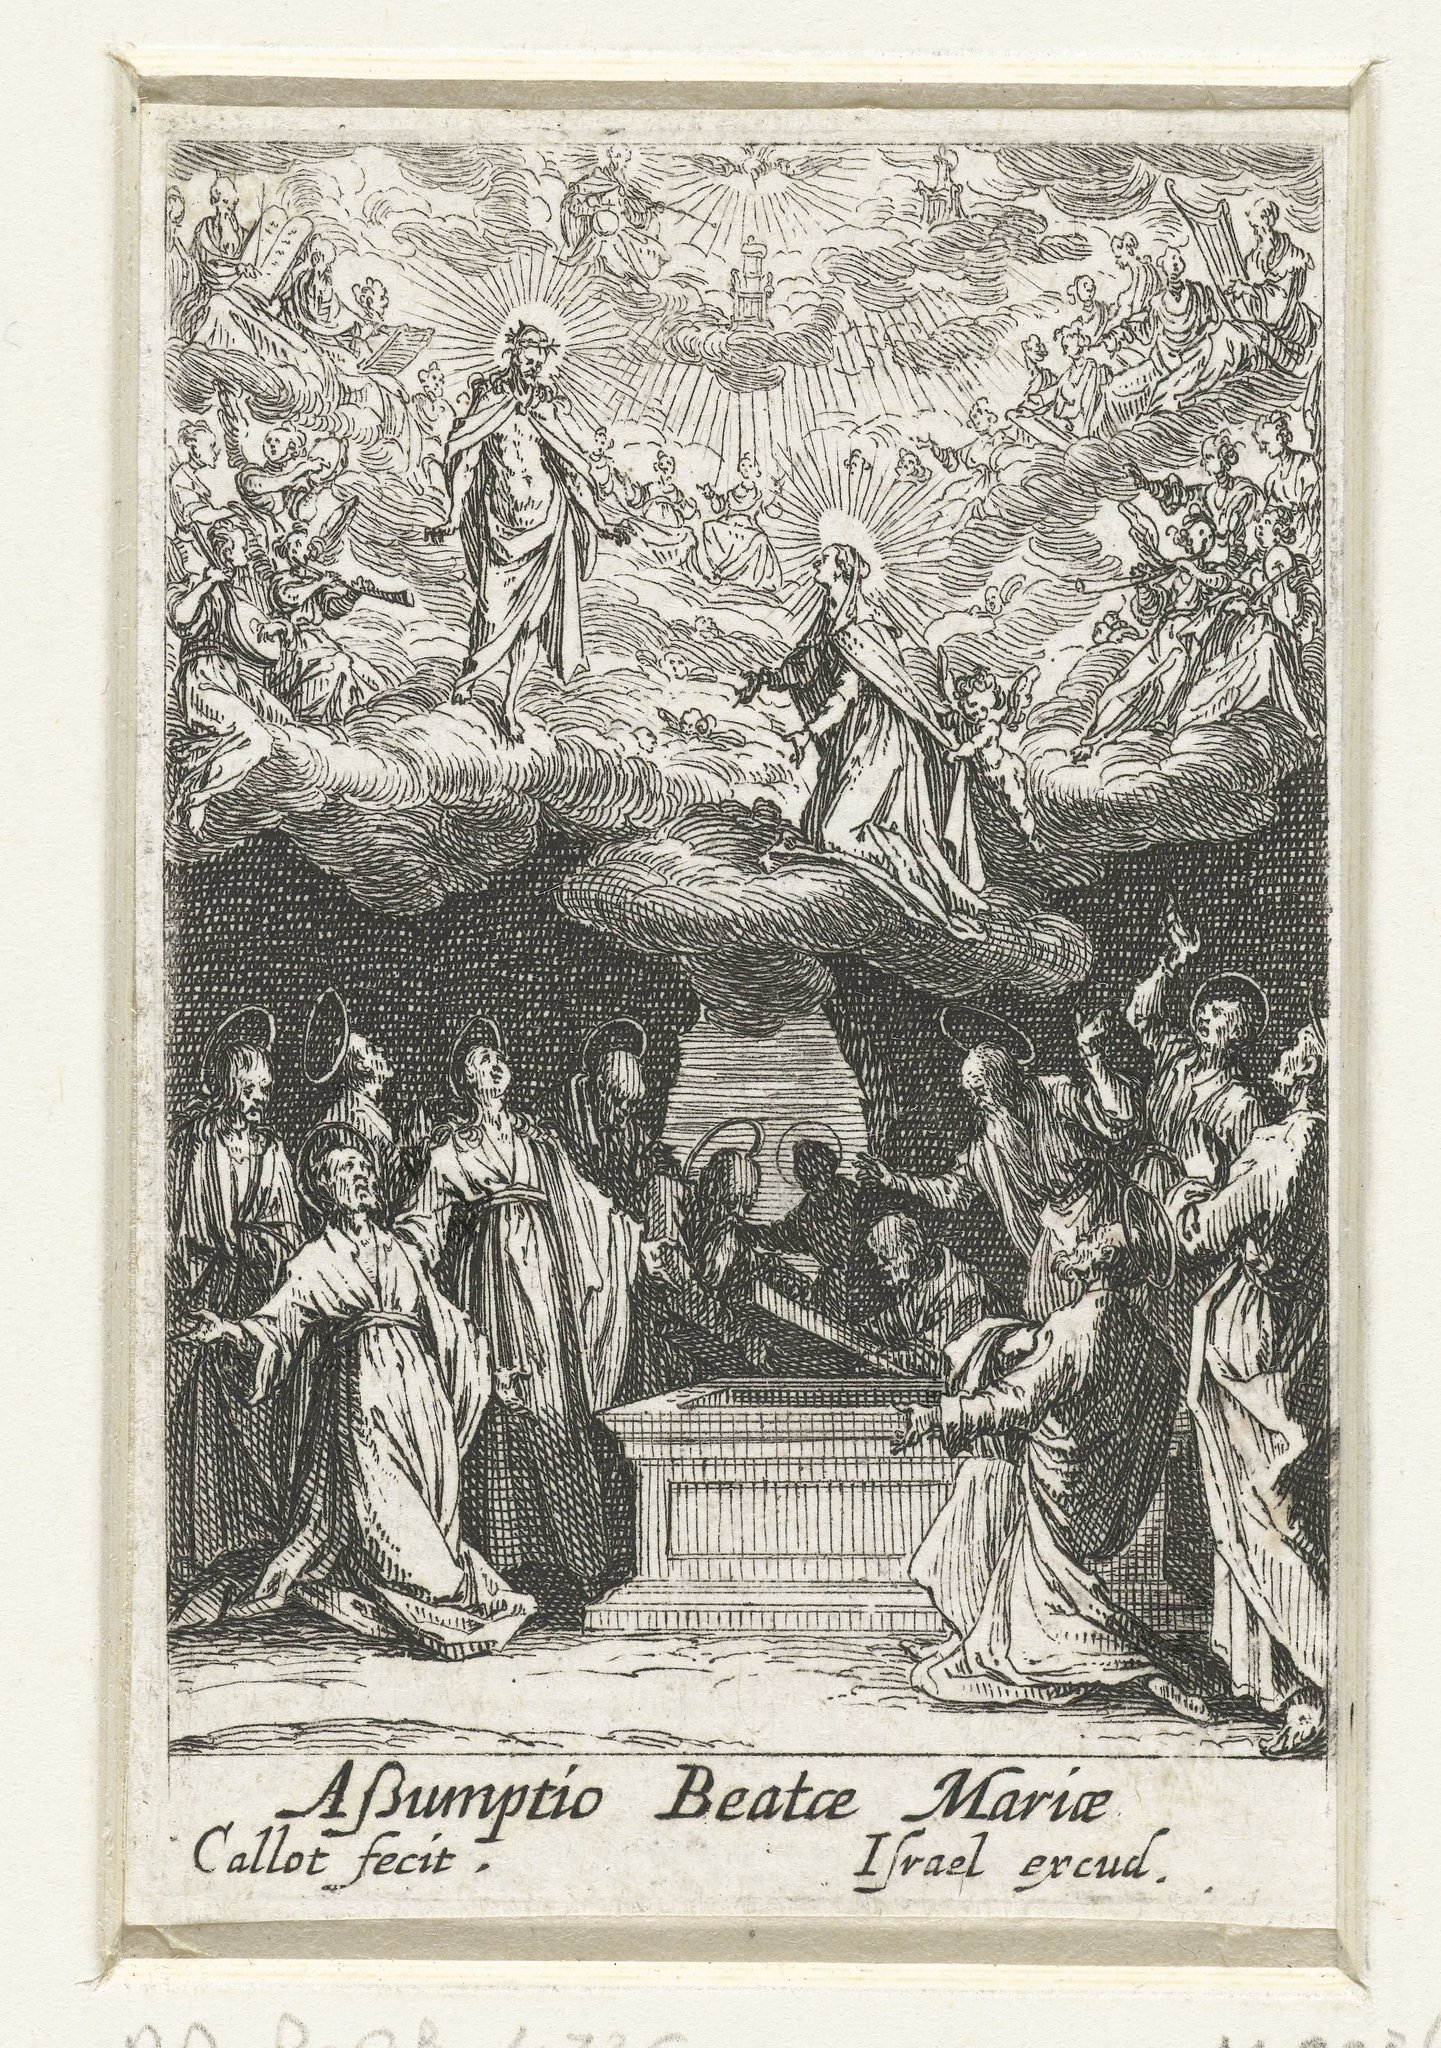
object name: print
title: Assumptio Beatae Mariae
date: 1633-1634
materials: paper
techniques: etching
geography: nancy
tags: the assumption of mary ('assumptio corporis'): she is borne into heaven by angels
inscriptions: collector's mark: Lugt 240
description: De apostelen staan om een leeg graf en kijken omhoog, waar Maria in de hemel door Christus wordt ontvangen. Onder de voorstelling een onderschrift in Latijn. Deze prent is onderdeel van een reeks prenten rond het leven van Maria, bestaande uit een titelprent en dertien verhalende voorstellingen.